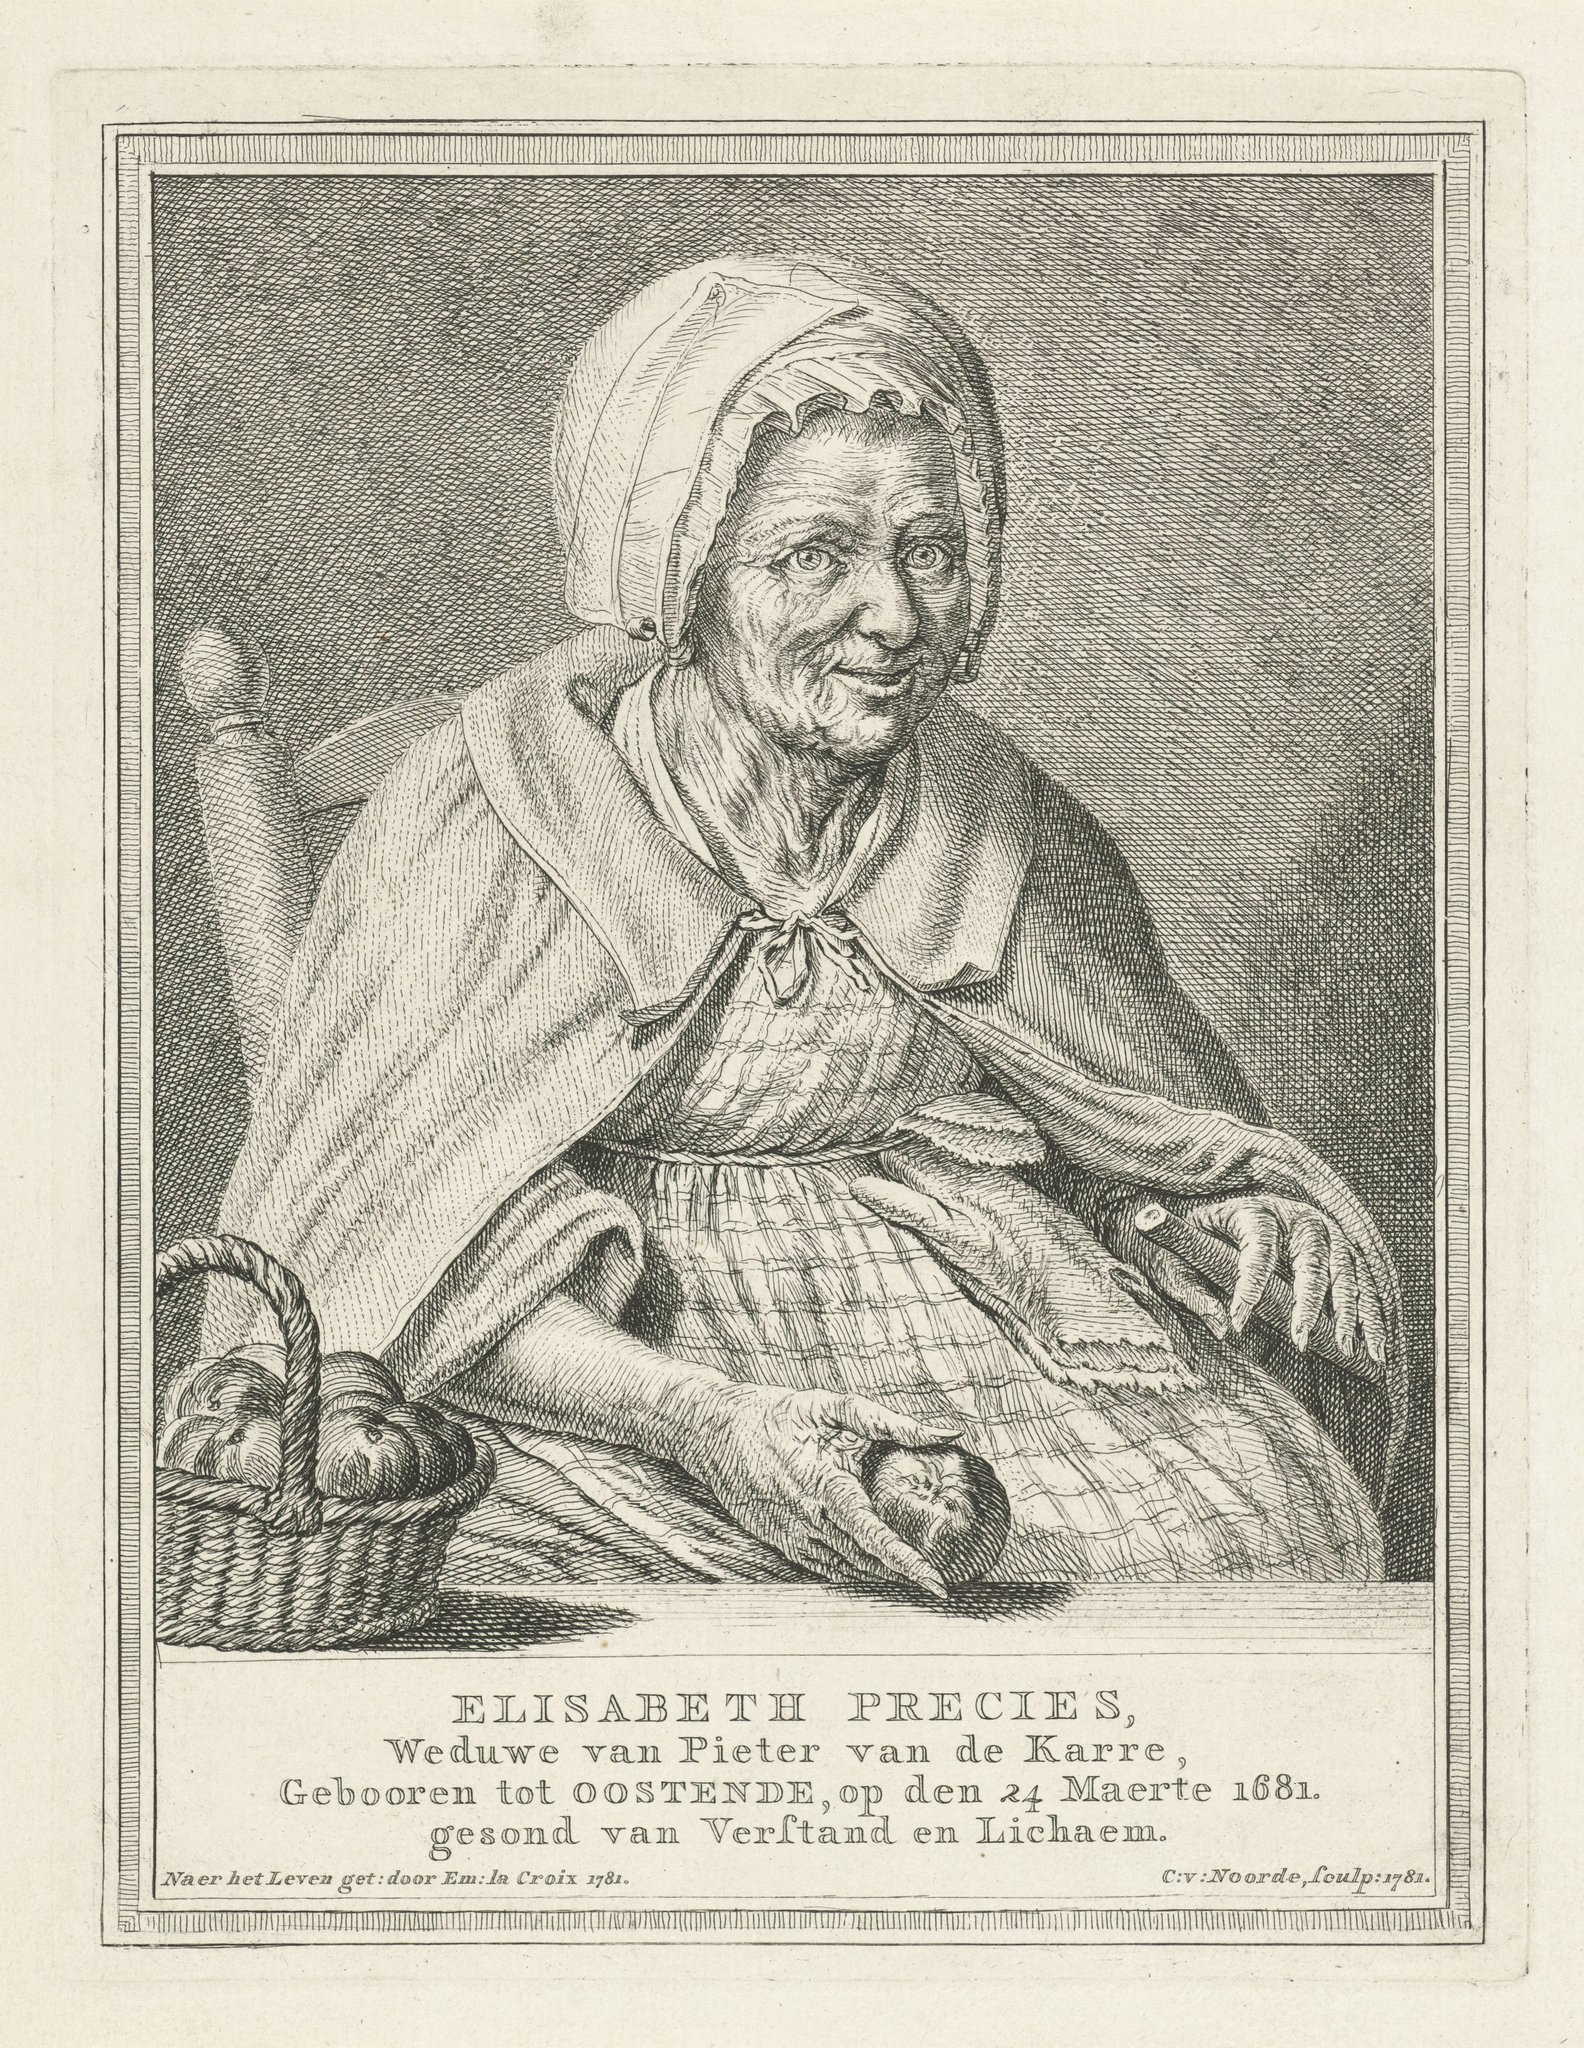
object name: print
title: Portret van Elisabeth Precies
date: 1781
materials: paper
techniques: engraving, etching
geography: haarlem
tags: oostende, elisabeth precies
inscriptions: collector's mark: Lugt 2228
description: Portret van Elisabeth Precies, op 100-jarige leeftijd, met een appel in haar hand.